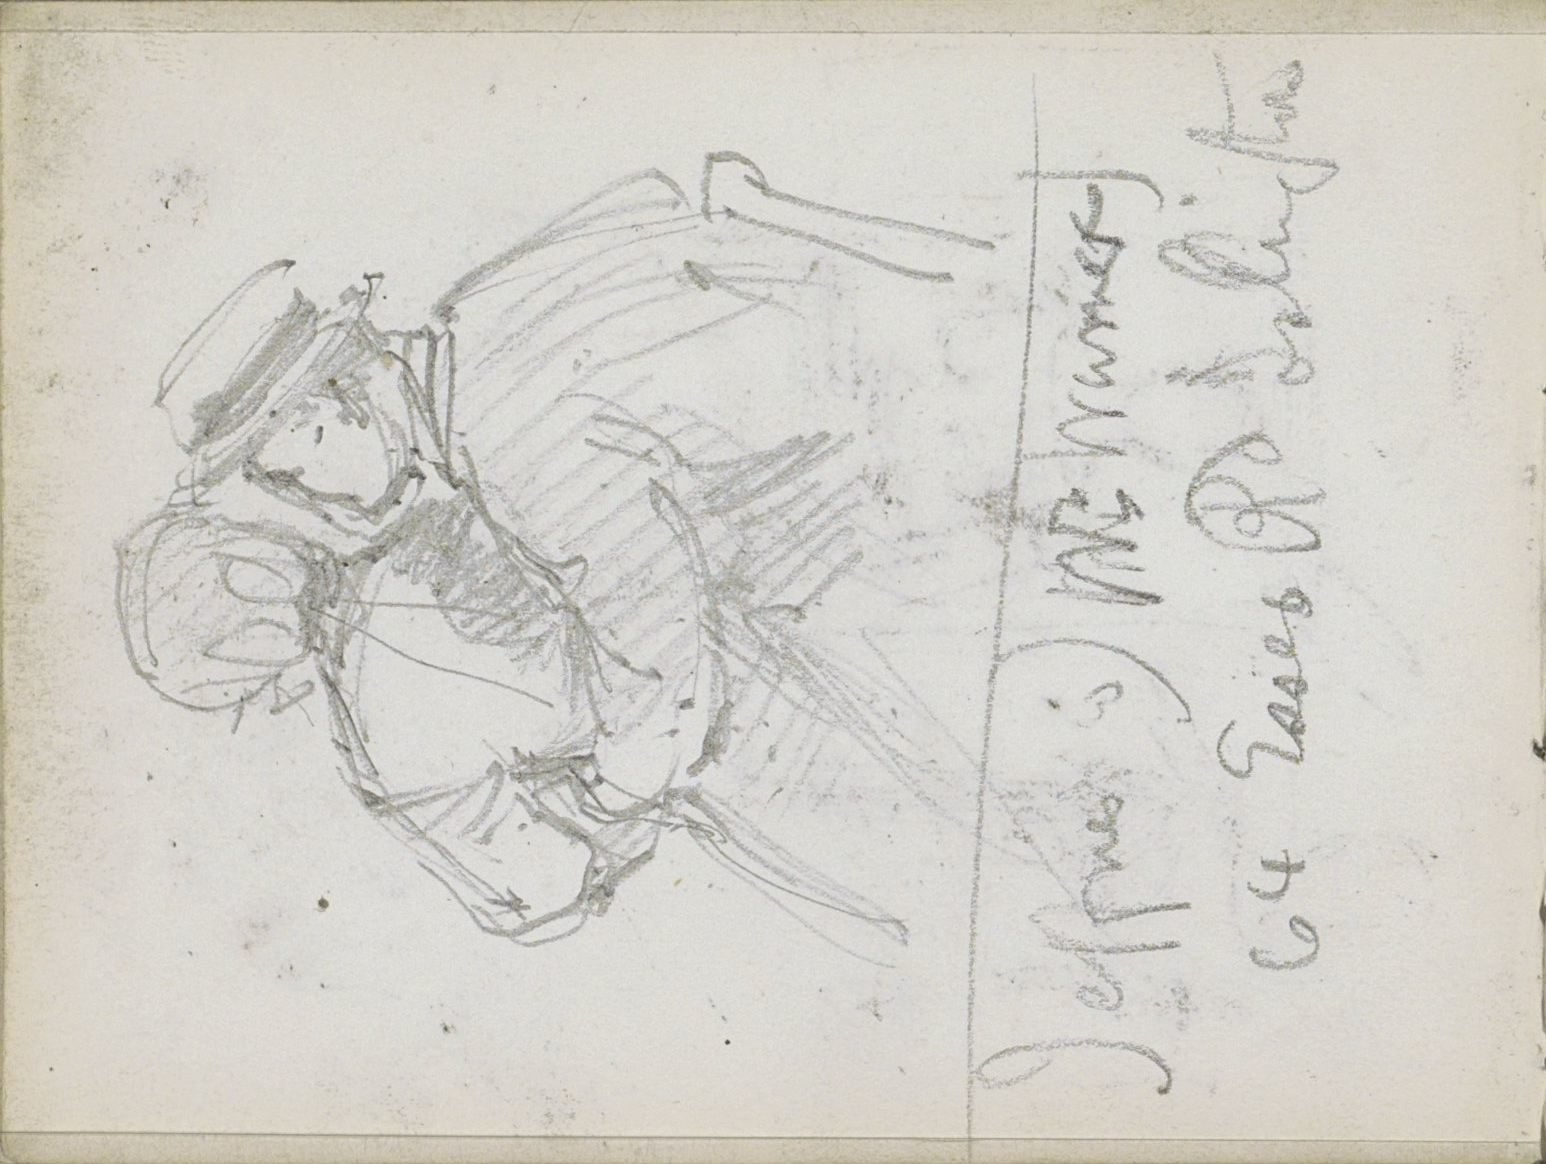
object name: sketchbook leaf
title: Man zittend op een stoel met een meisje op schoot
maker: george clausen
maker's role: draughtsman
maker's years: 1852-1912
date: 1874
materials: paper, pencil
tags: sitting figure, adult man, girl (child between toddler and youth), chair, sitting in someone's lap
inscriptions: annotation: ‘Je[...]nes Ms Warner/ 64 Essex Rd [...]’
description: Blad 3 verso uit een schetsboek met 37 bladen.